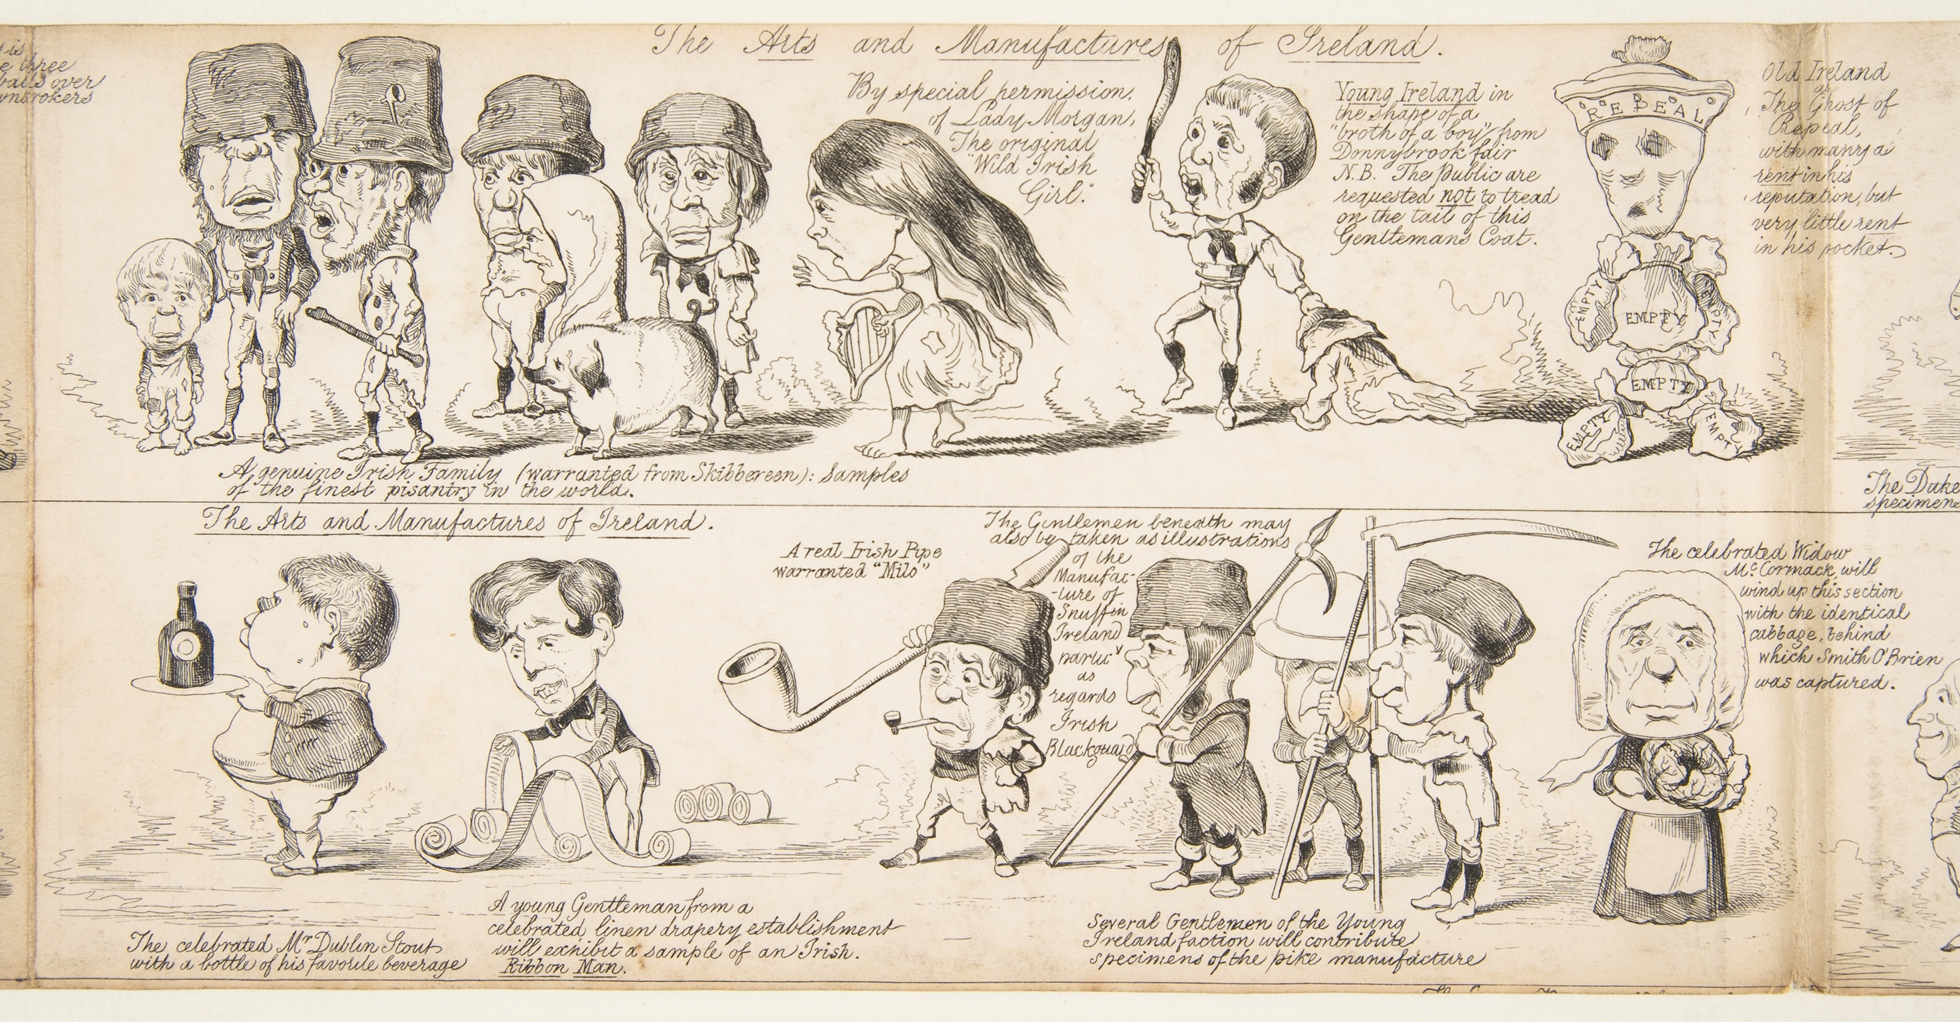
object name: print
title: The Great Exhibition "Wot is to Be", Probable Results of The Industry of All Nations in The Year '51, Showing What is to be Exhibited, Who is To Exhibit, in Short How Its All Going to Be Done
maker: george augustus sala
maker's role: author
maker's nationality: british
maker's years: 1828-1895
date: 1850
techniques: engraving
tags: animals,men,women